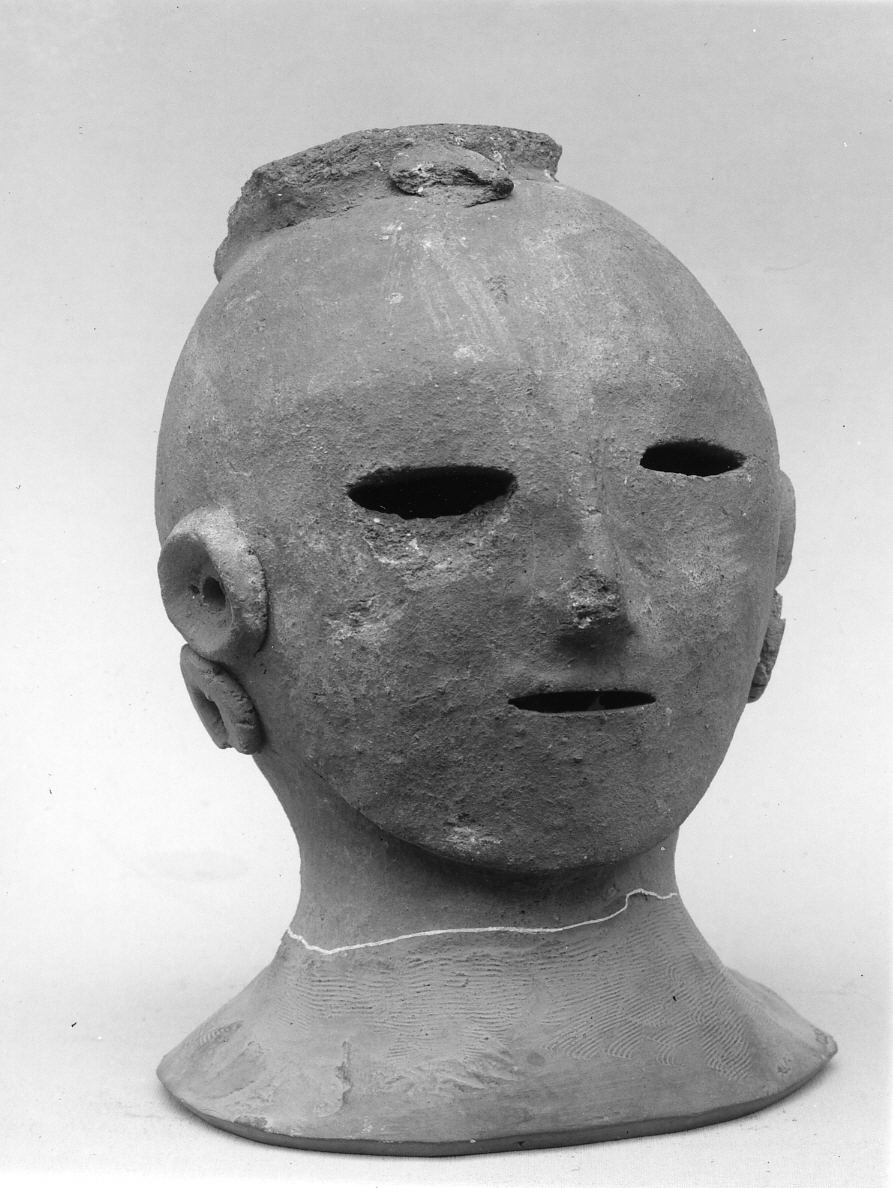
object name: haniwa head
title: Head of a Female Haniwa Figure with Headdress and Earrings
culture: japanese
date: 501-600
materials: earthenware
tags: heads